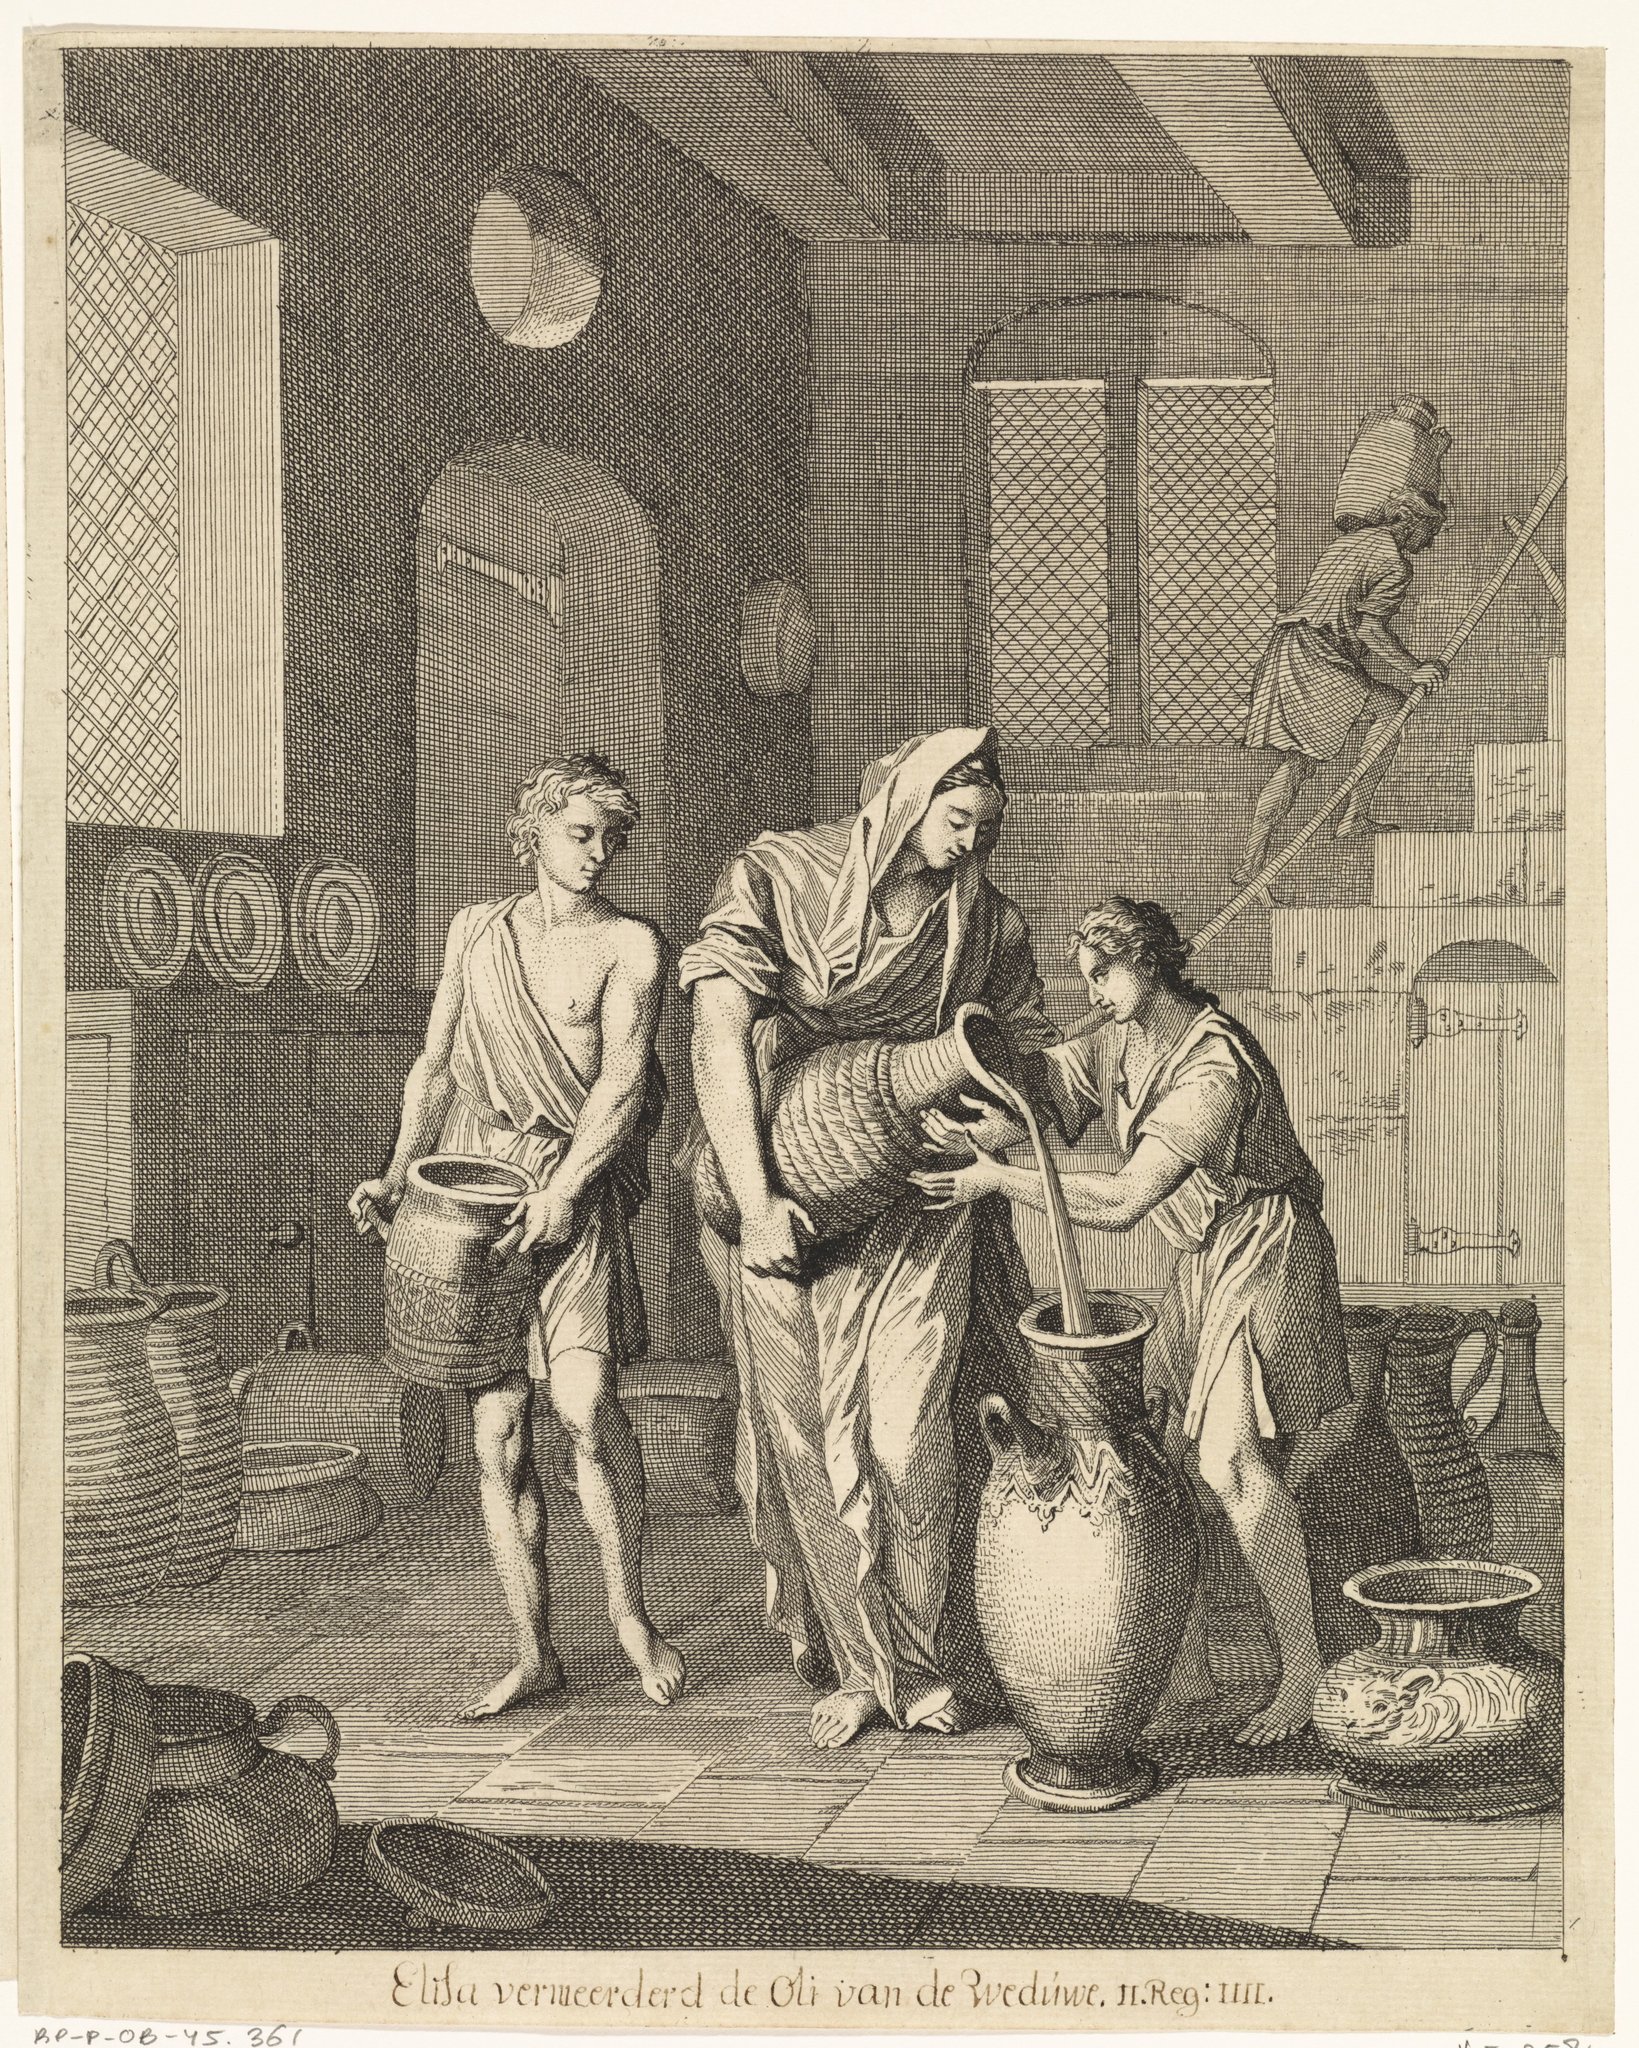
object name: print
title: Elisa helpt een arme weduwe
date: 1708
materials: paper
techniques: etching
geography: nuremberg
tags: the widow's oil: the little oil a woman has in store increases so that she and her son are able to fill many borrowed jars with it (2 kings 4:1-7)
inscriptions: collector's mark: Lugt 2228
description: Proefdruk van een prent welke is opgenomen als illustratie in: Historiae Celebriores Veteris Testamenti. Christoph Weigel, 1708.